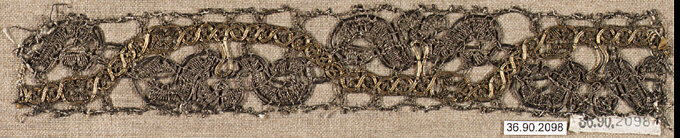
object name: piece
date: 1701-1800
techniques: lace